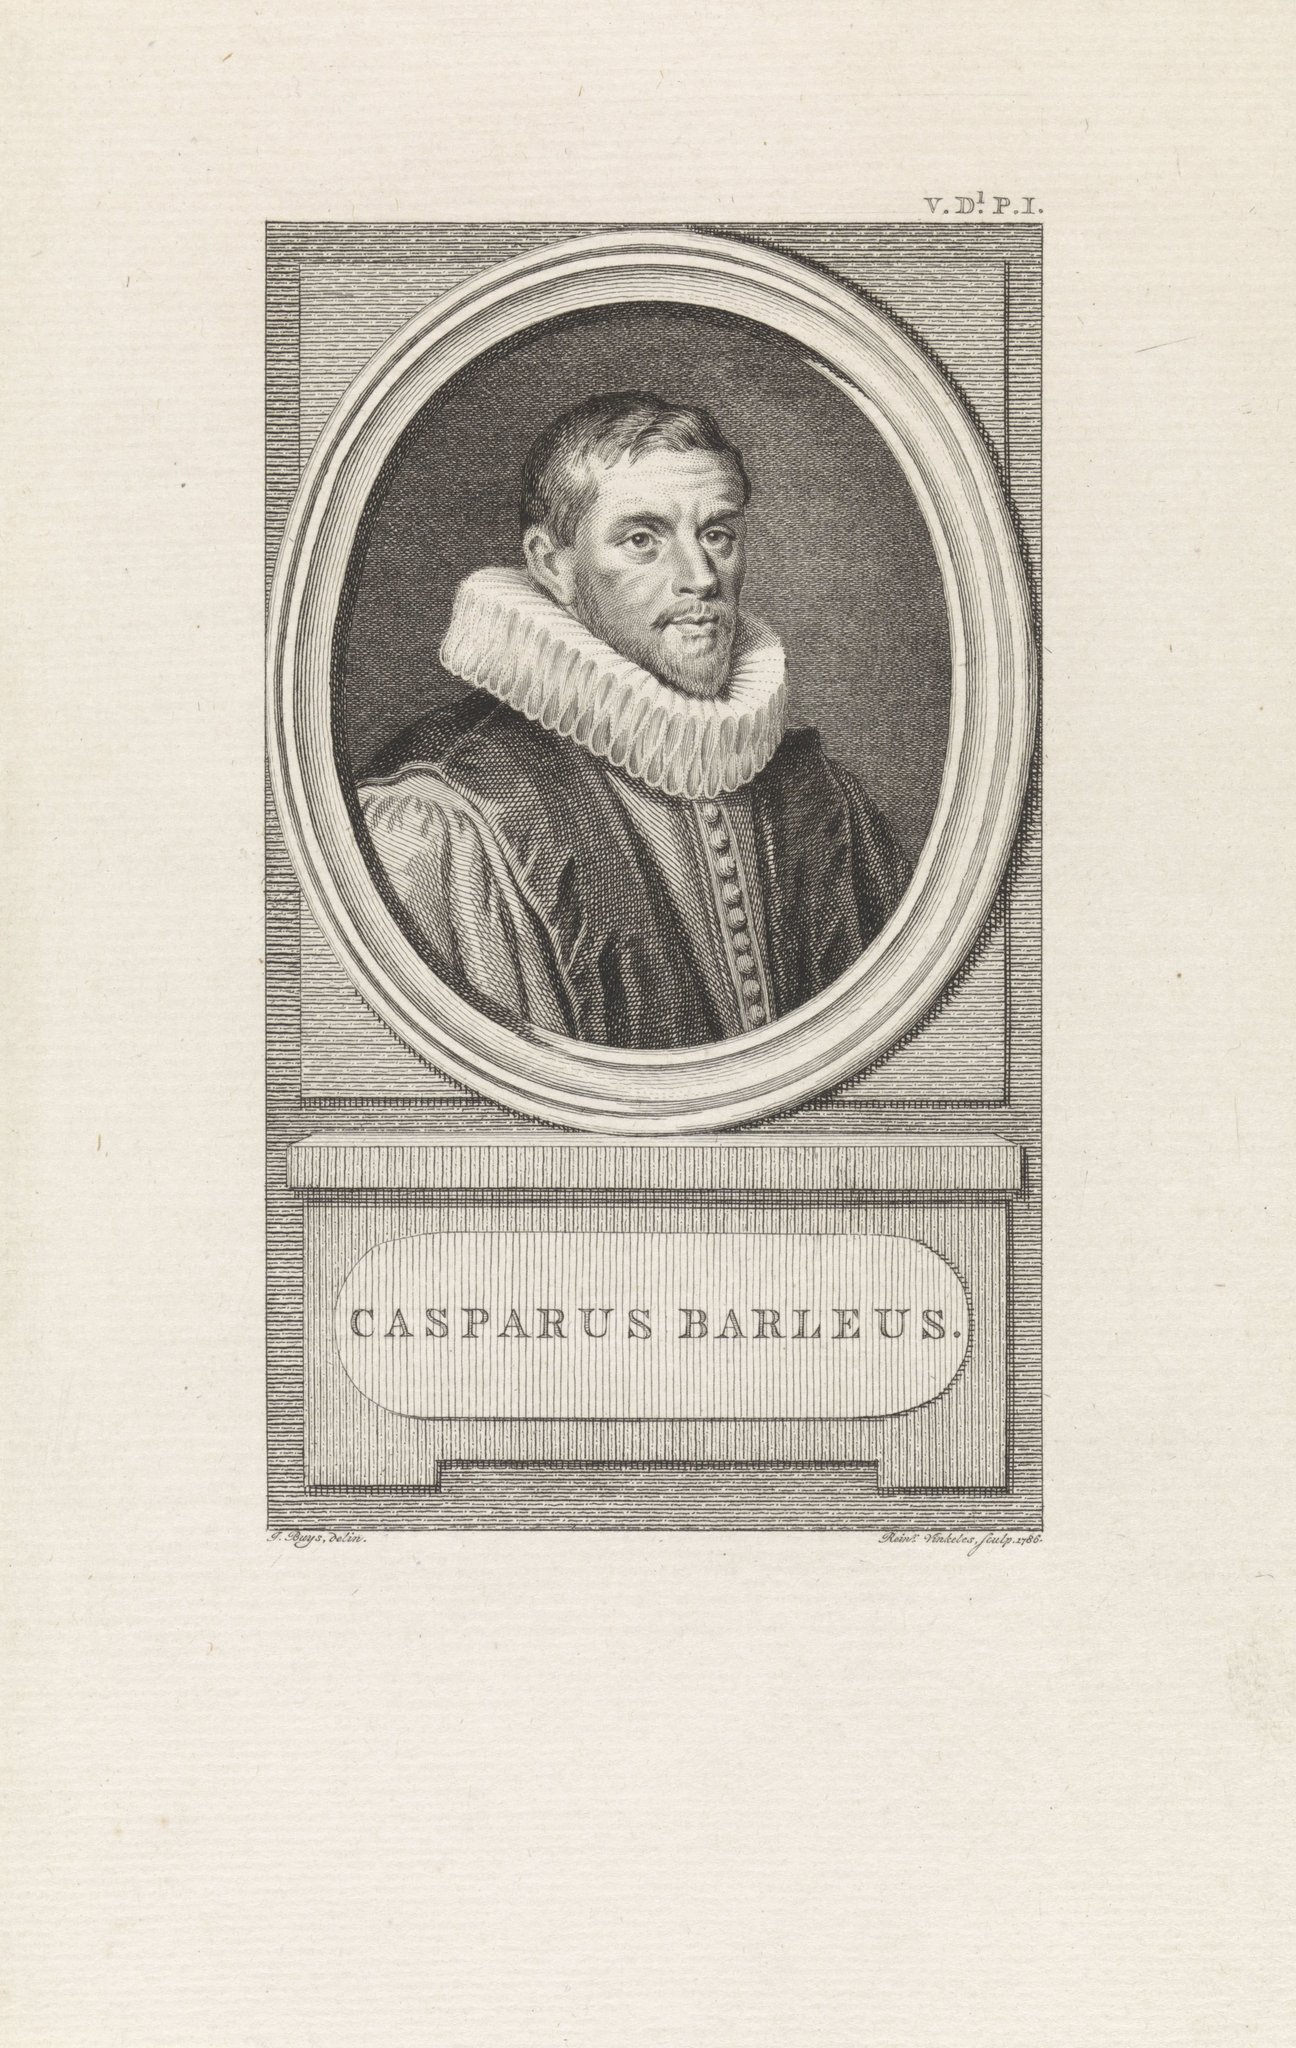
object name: book illustration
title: Portret van Caspar van Baerle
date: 1786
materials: paper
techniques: engraving, etching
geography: amsterdam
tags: antwerp, amsterdam, caspar van baerle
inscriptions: collector's mark: Lugt 2228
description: Prent gebruikt als boekillustratie in: Kok, Jacobus. Vaderlandsch woordenboek : met kaarten, plaaten en pourtraitten. Amsterdam: Johannes Allart, 1785-1796. Deel V.